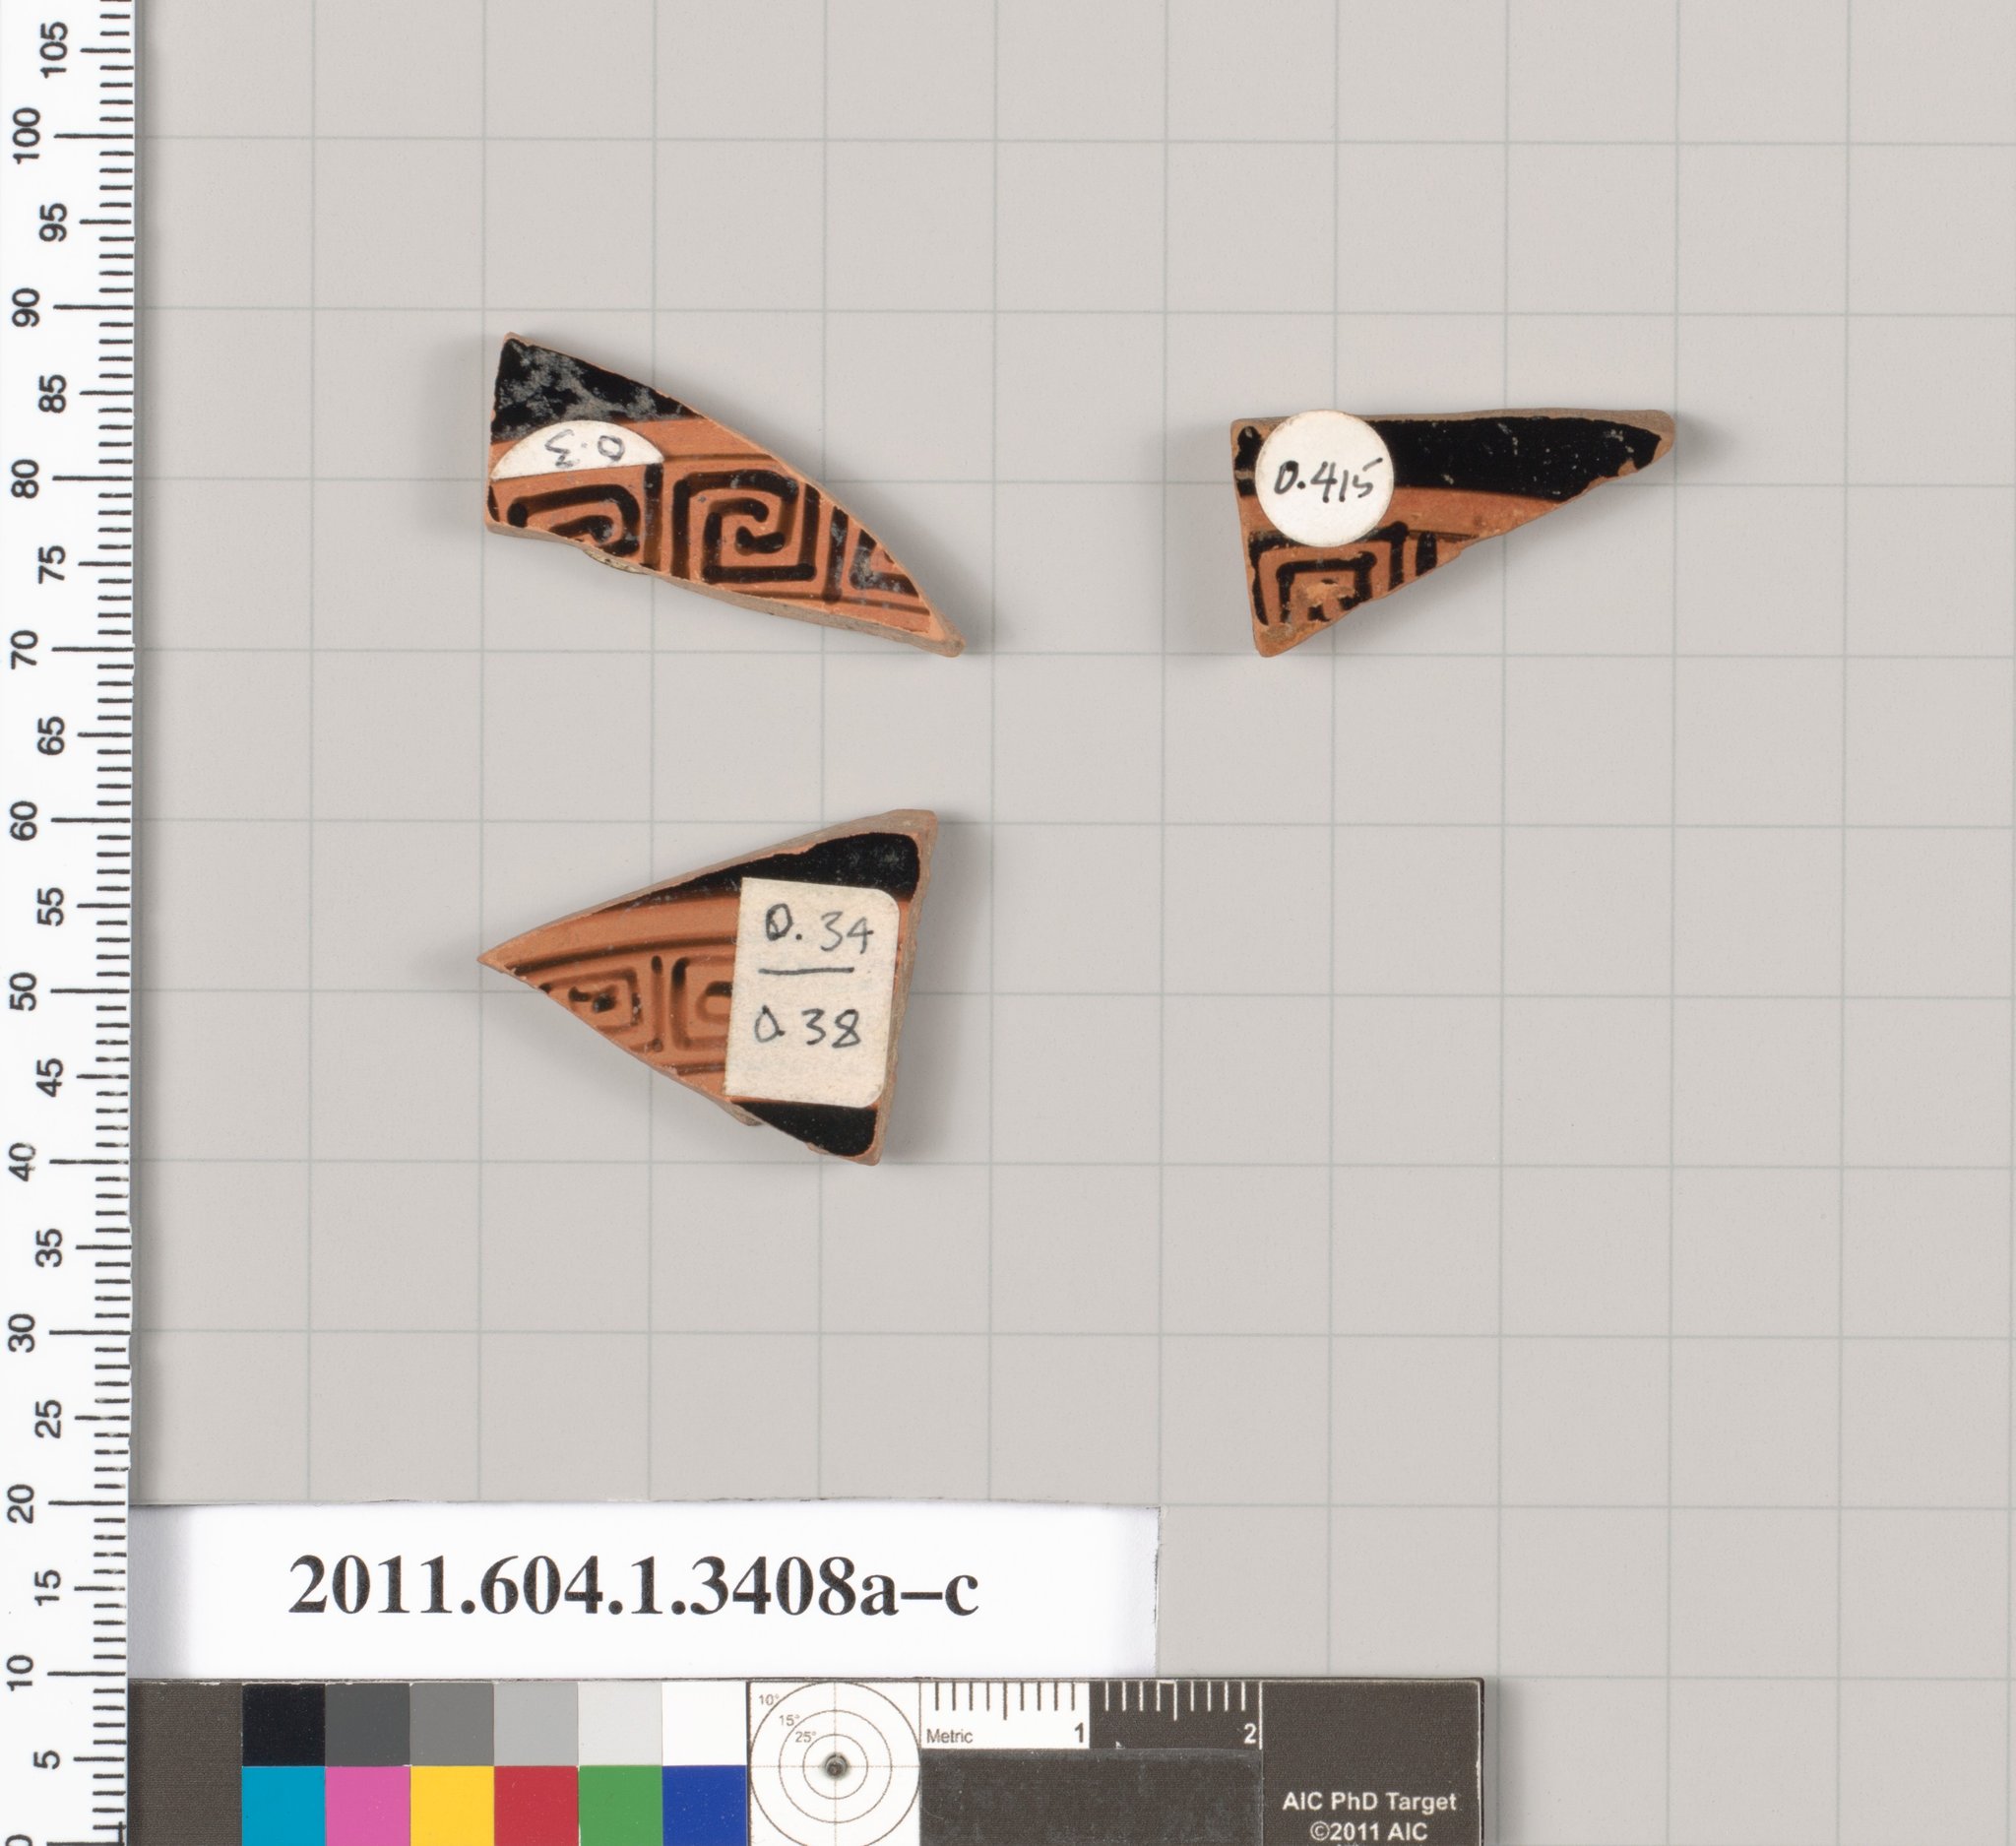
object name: kylix fragment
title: Terracotta fragments of kylikes (drinking cups)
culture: greek, attic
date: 510-470 BCE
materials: terracotta